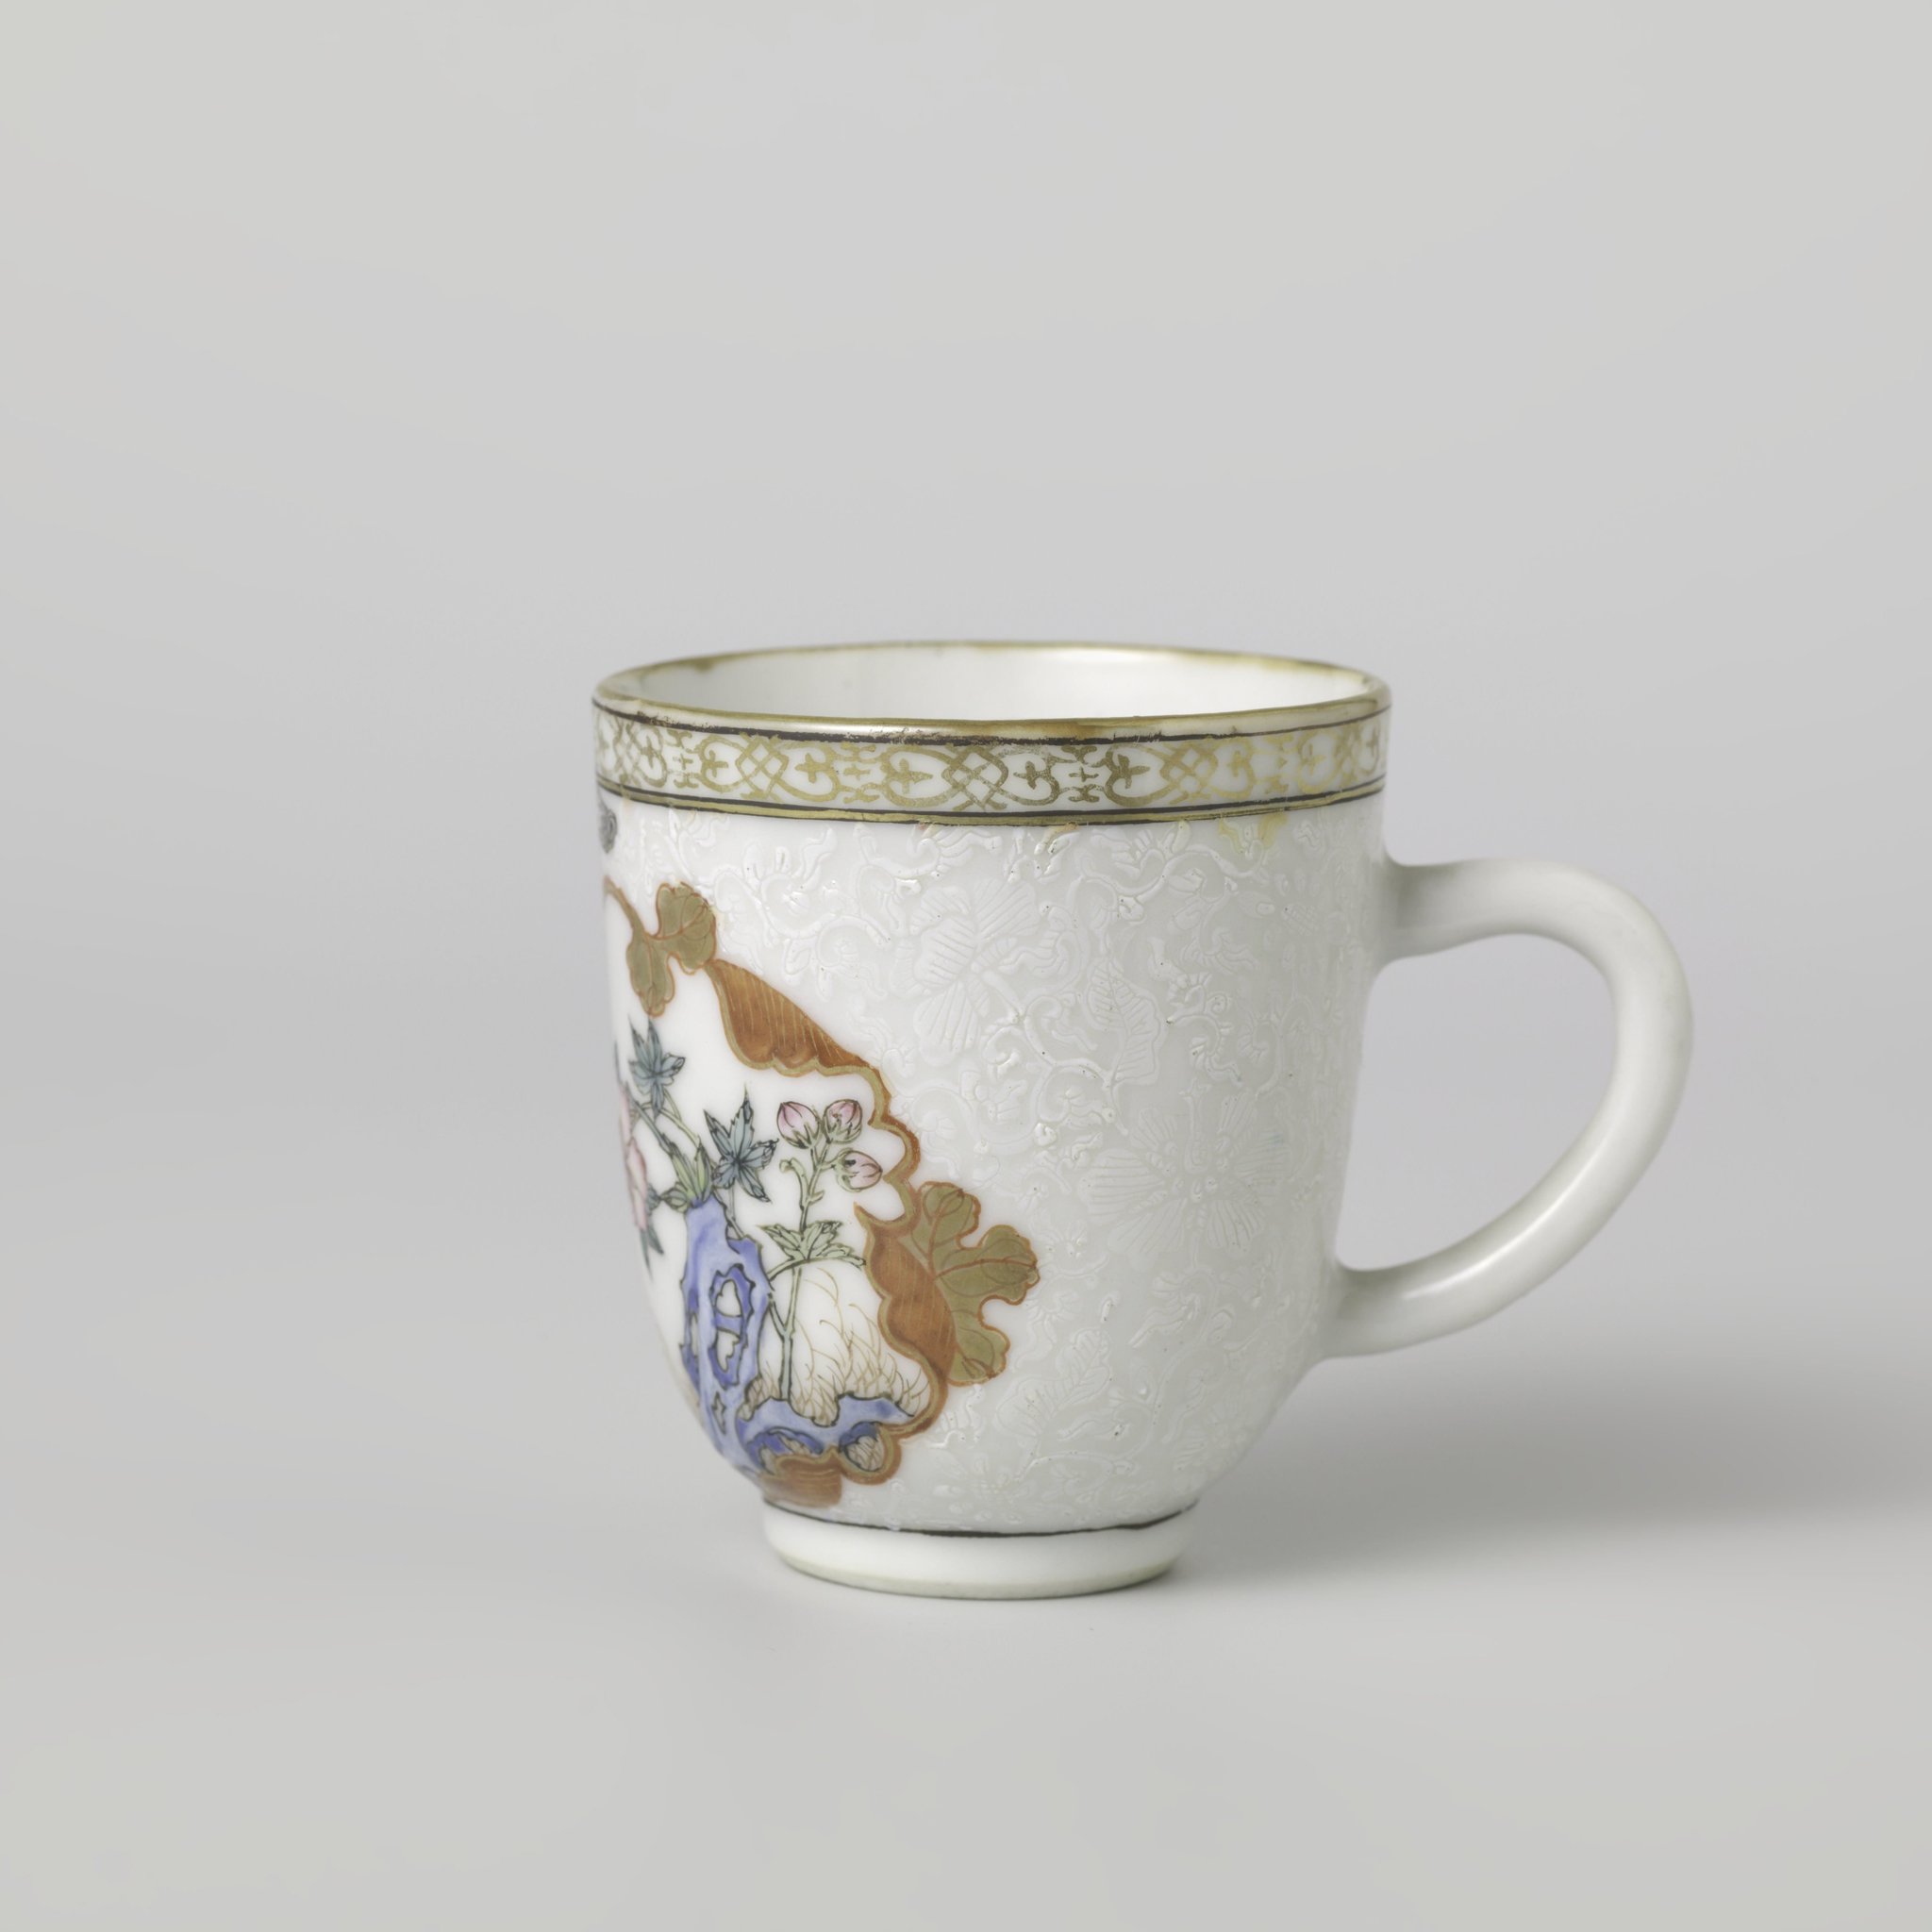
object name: oorkop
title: Cup with handle with a crane near a peony plant and rock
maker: Anonymous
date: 1725-1749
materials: glaze, gold, paint, porcelain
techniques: firing, gilding, turning, vitrification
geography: china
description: Gedecoreerd in emails, goud en bianco sopra bianco met vogels en bloeiende planten.